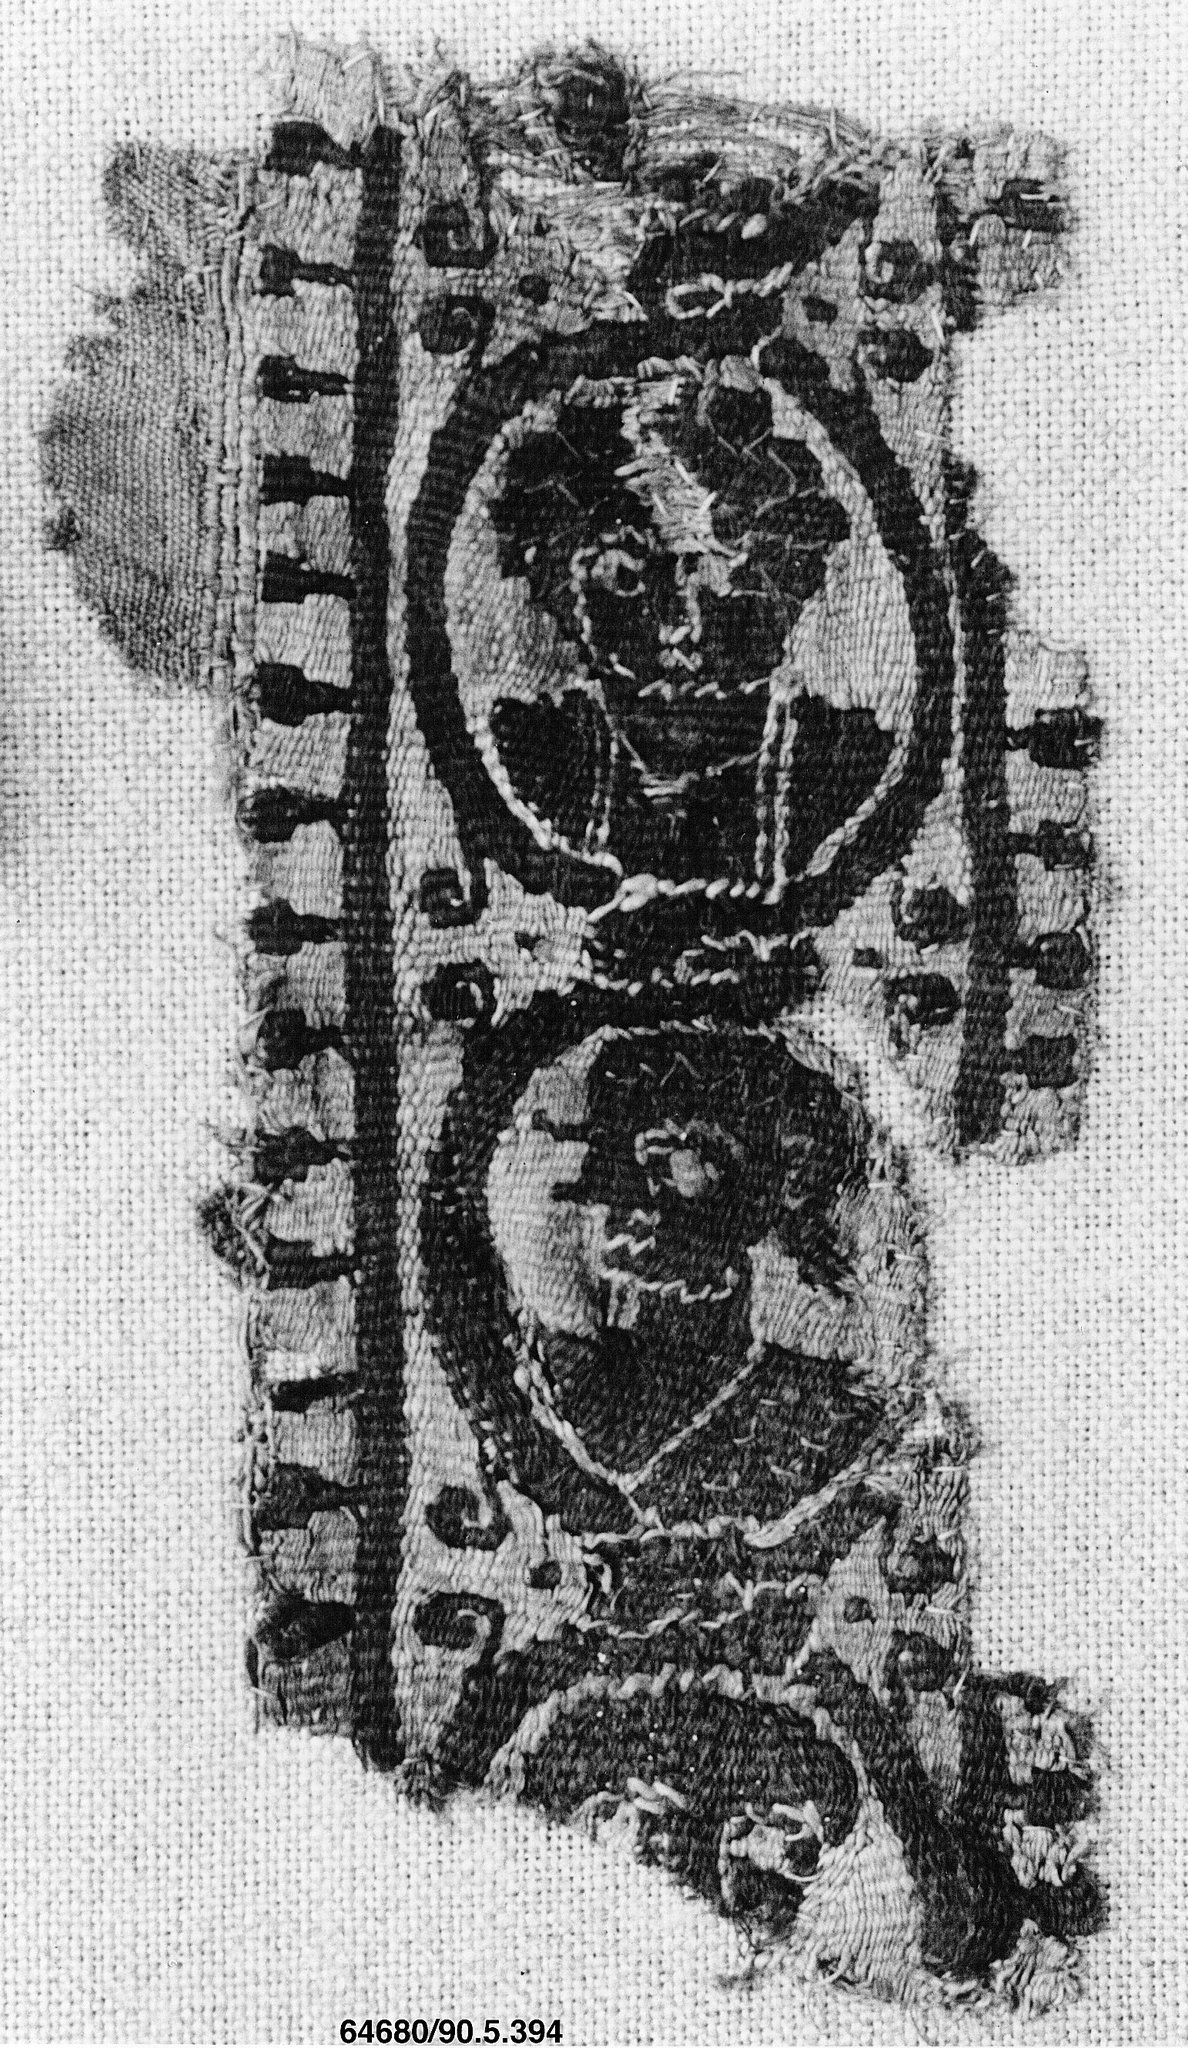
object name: textile fragment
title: Fragment of a Shoulder Band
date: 201-400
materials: linen, wool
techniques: weave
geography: egypt